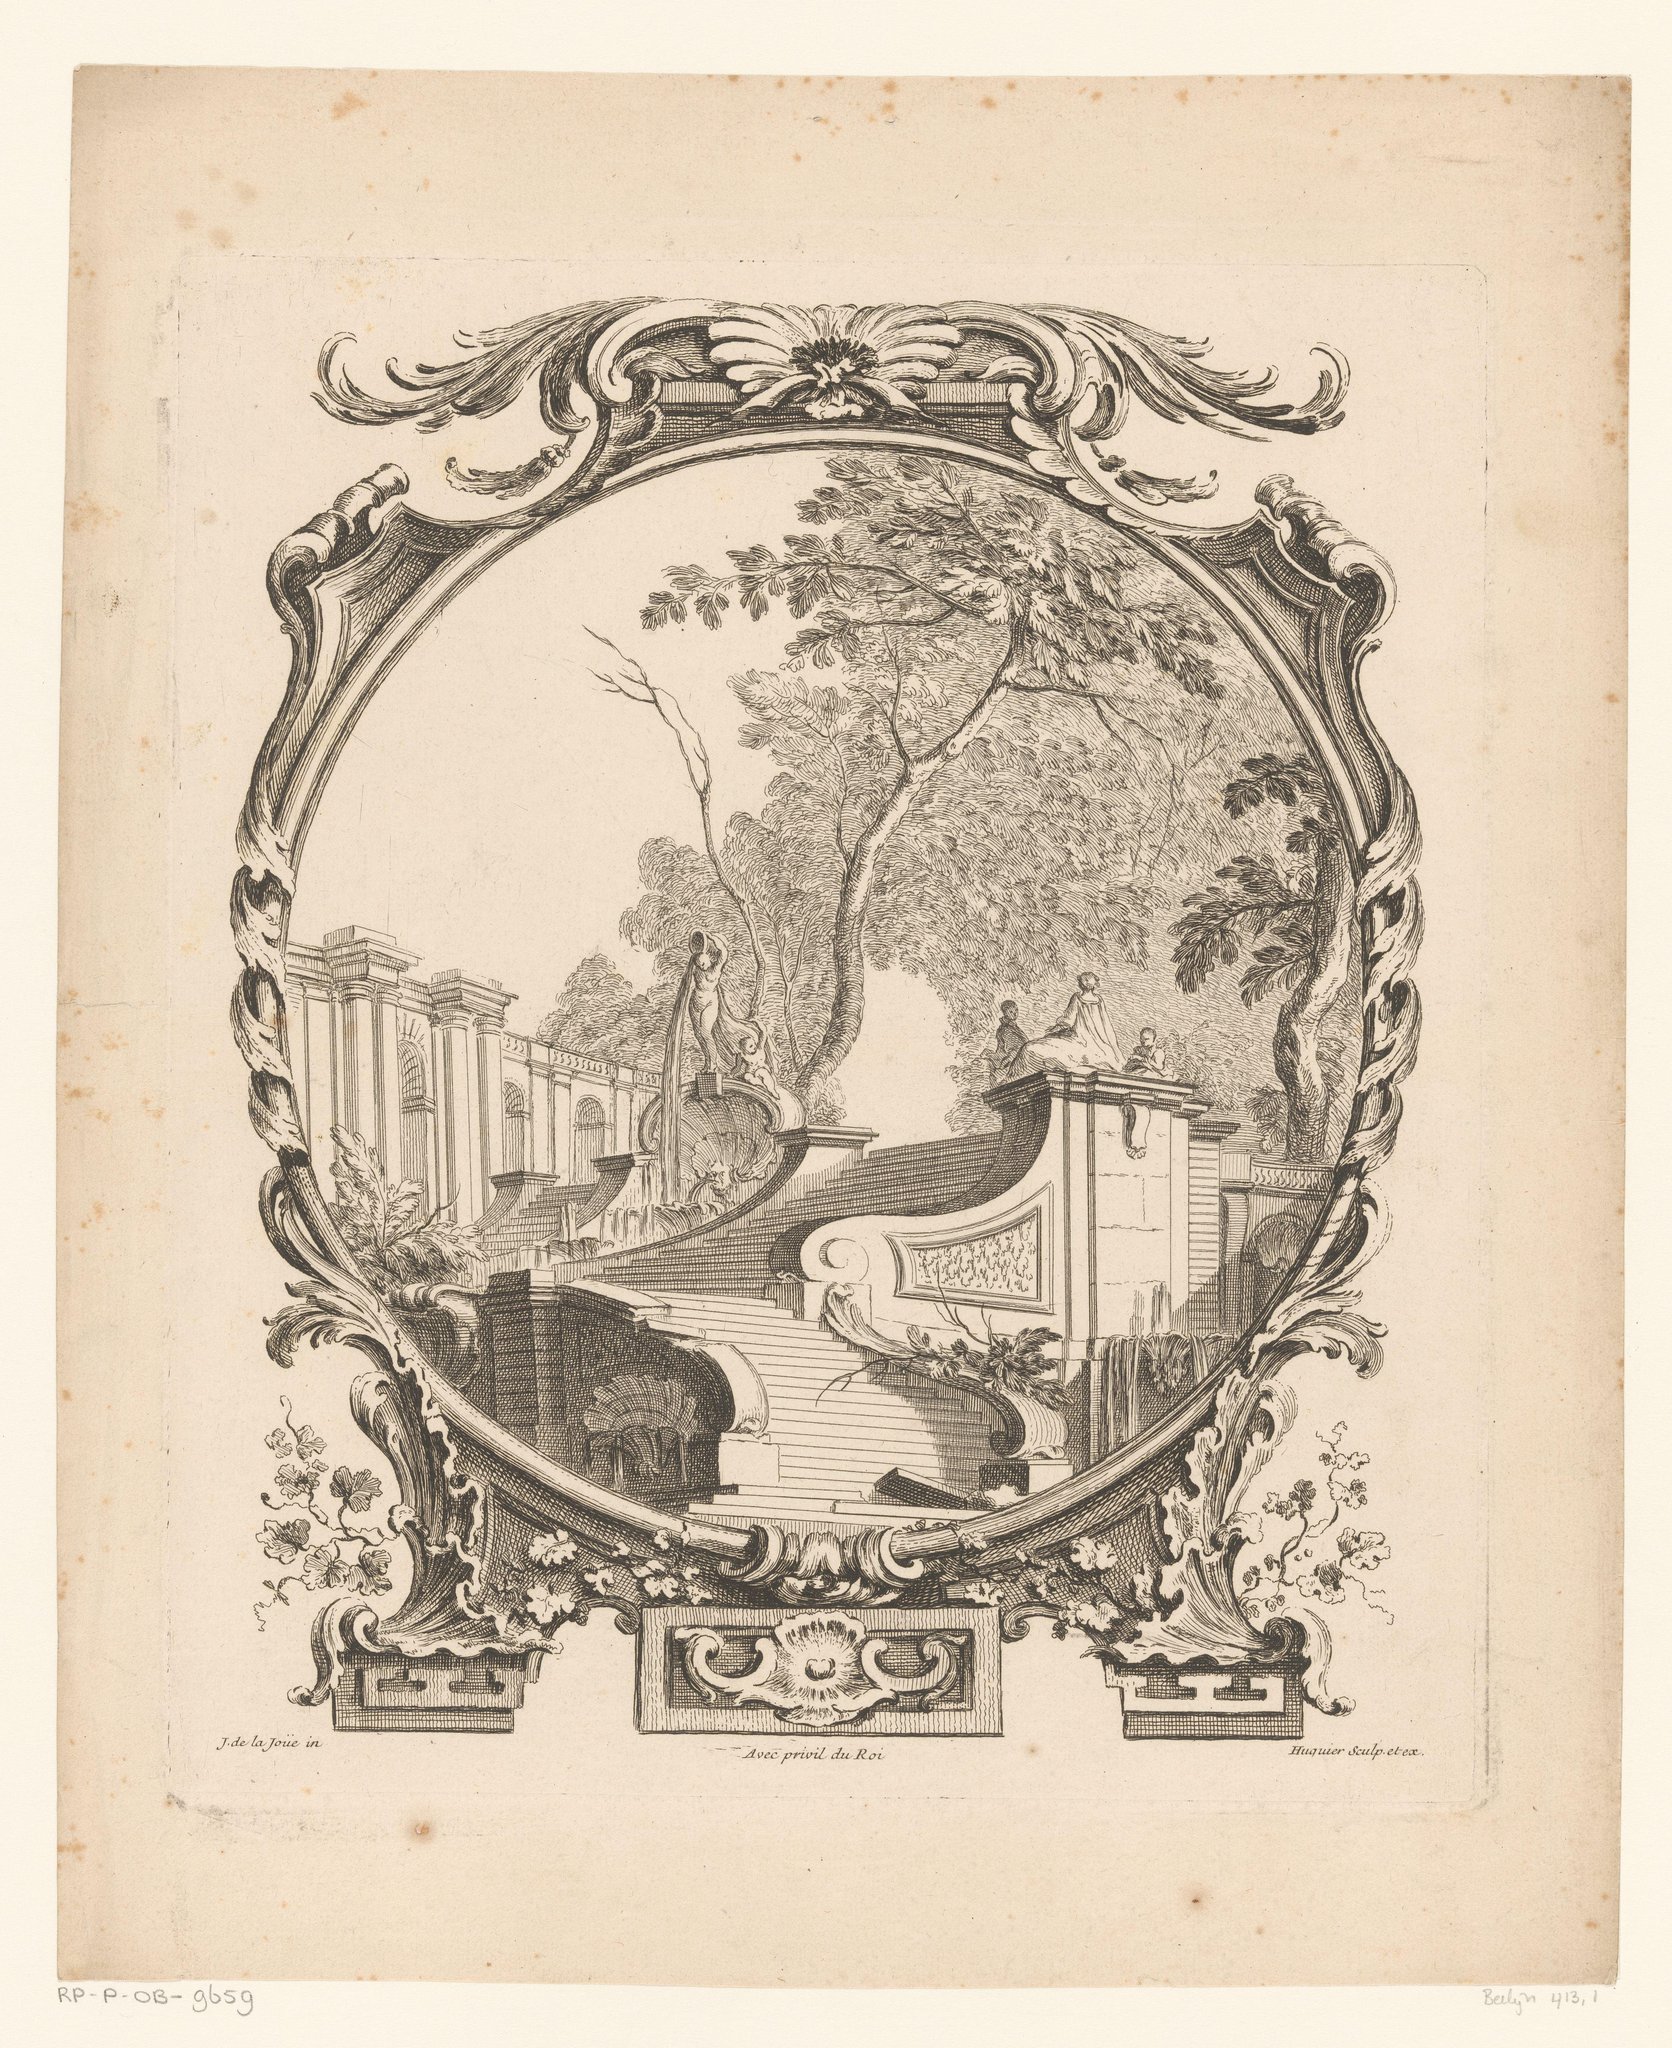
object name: print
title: Premier Livre De divers Morceaux D'Architecture Paysages Et Perspectives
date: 1731-1761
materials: paper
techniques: etching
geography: paris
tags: sitting figure, garden, garden fountain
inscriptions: collector's mark: Lugt 2228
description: Een tuin met rechts onder en links boven fonteinen met een staande vrouw met vaas en een putto. In het midden leidt een trap omhoog naar drie zittende figuren. Links in de achtergrond arcades. Rondom de voorstelling een ronde omlijsting met wijnranken.